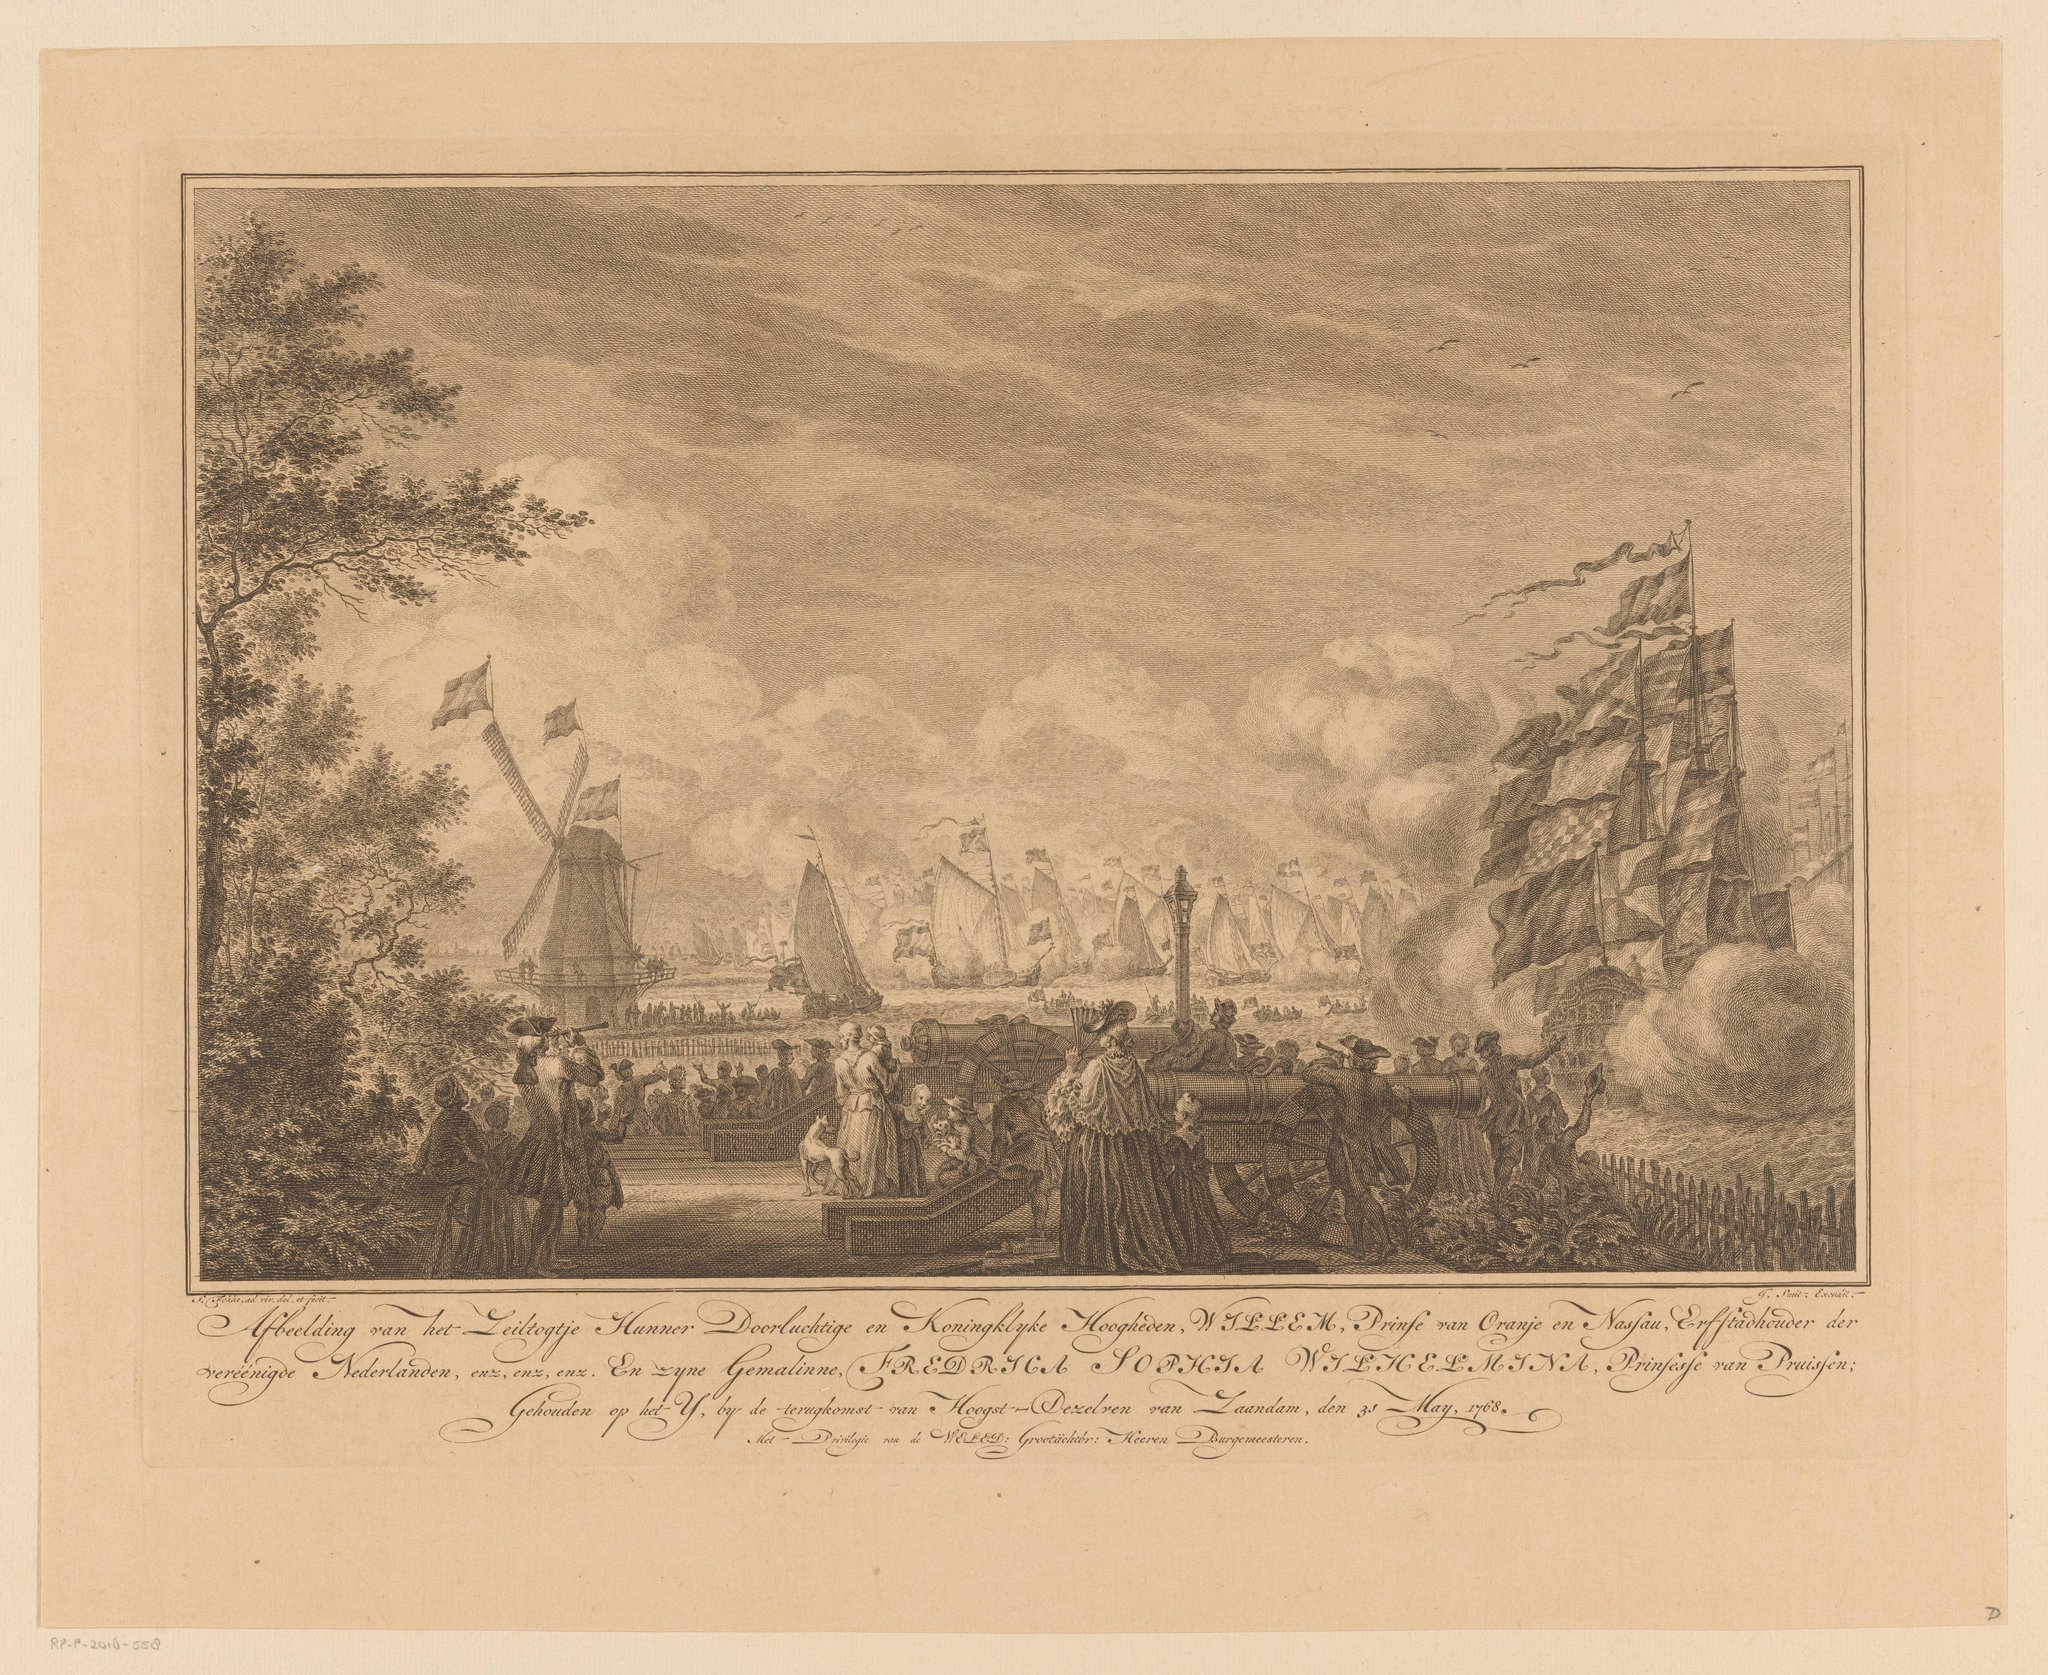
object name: print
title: Zeiltocht van Willem V en Wilhelmina van Pruisen op het IJ, 1768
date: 1772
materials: paper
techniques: engraving, etching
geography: amsterdam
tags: the hague, william v (prince of orange), berlin, draughtsman, wilhelmina of prussia (princess of orange), public festivities on the occasion of royal events - aa - festivities on the water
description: Zeiltocht van stadhouder Willem V en prinses Wilhelmina van Pruisen op het IJ bij terugkomst uit Zaandam, 31 mei 1768. Gezicht op de vele schepen op het water, met toeschouwers bij kanonnen op de kade. Links een molen.